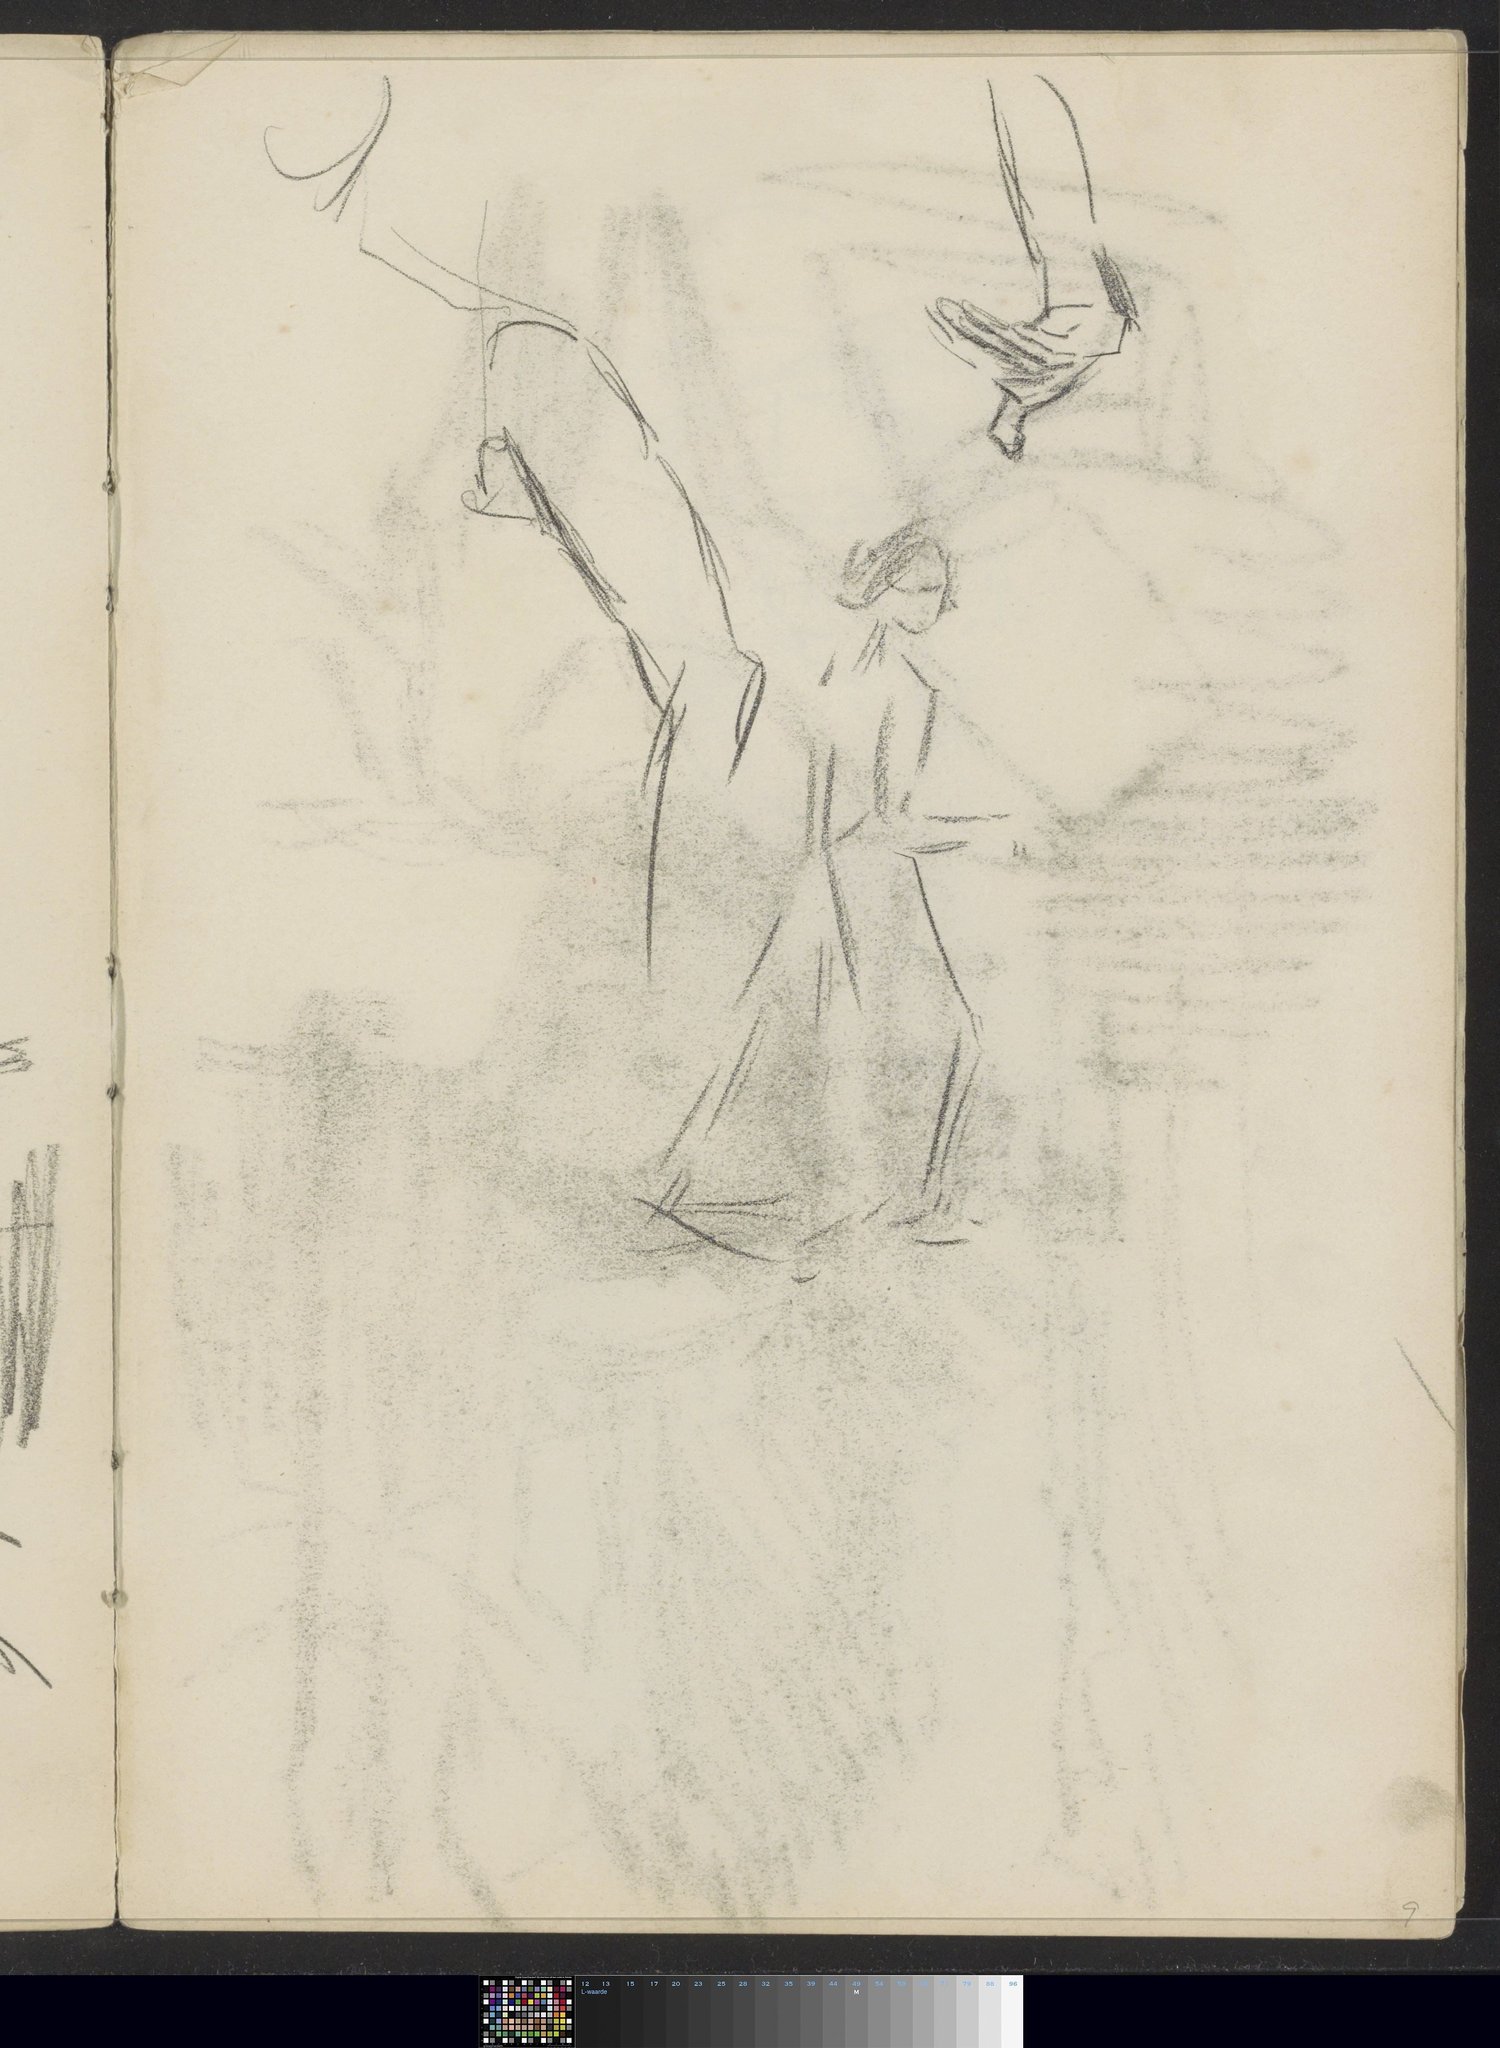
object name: sketchbook leaf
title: Figuurstudies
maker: isaac israels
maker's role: draughtsman, painter, print maker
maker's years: 1865-1934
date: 1886-1934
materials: chalk, paper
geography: amsterdam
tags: arms, hand, adult woman (+ sideview, profile)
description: Een linkerarm, een hand en een lopende vrouw, in profiel. Blad 9 recto uit schetsboek LXVI-B met 25 bladen.